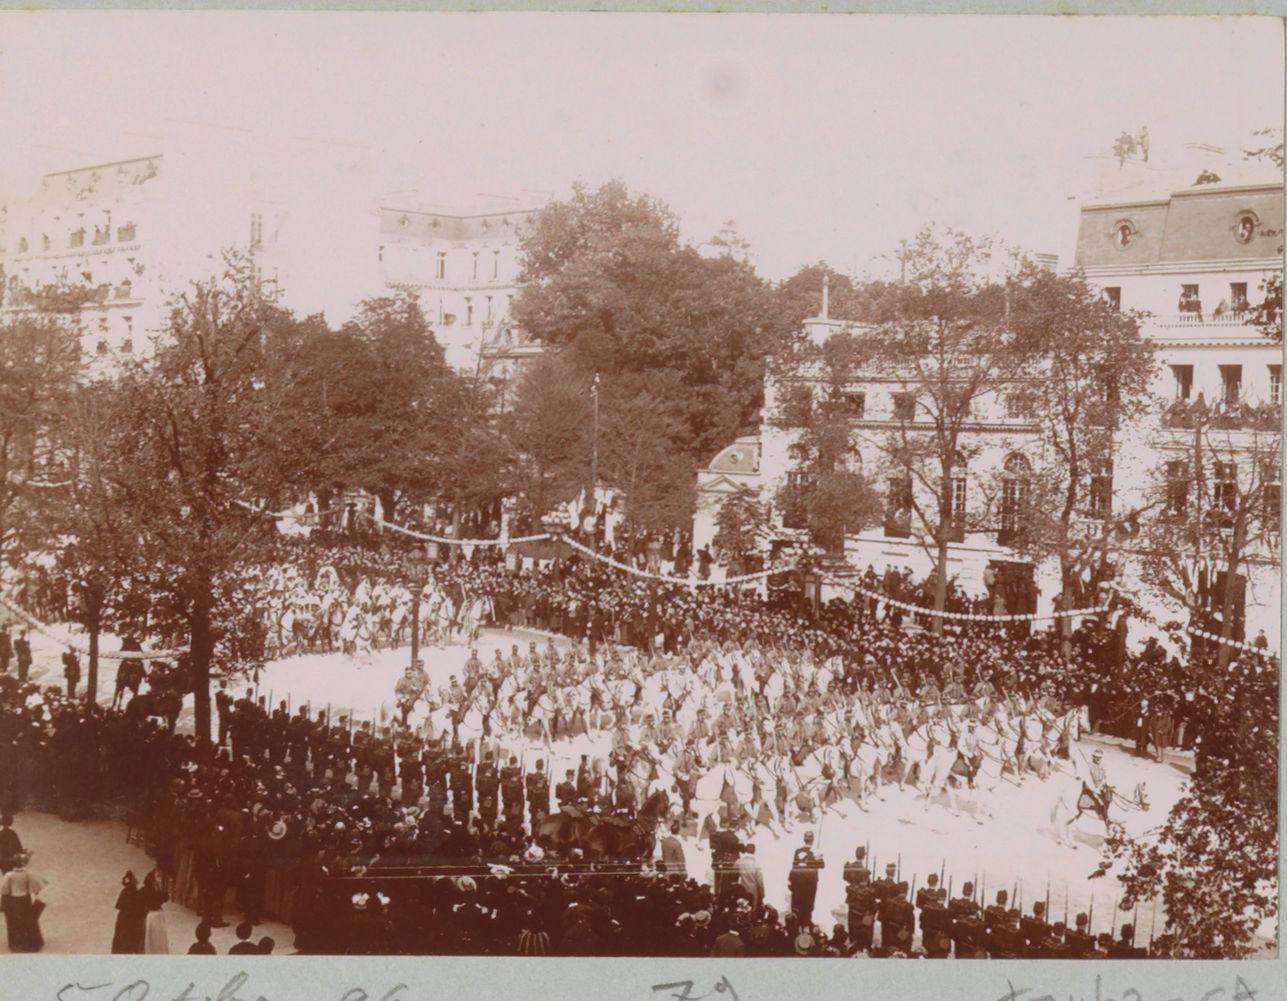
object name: photograph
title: Optocht met ruiters bij het bezoek van tsaar Nicolaas II van Rusland aan Parijs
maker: delizy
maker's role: manufacturer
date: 1896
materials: paper, photographic support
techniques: gelatin silver print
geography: paris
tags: land forces (+ cavalry, horsemen), festivities (+ parade, pageant, cavalcade ~ festive activities), paris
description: Onderdeel van Fotoalbum van een Franse amateurfotograaf met opnames van uitstapjes in Frankrijk, Spanje, België, Luxemburg en Nederland, de eerste automobielen en autoraces.